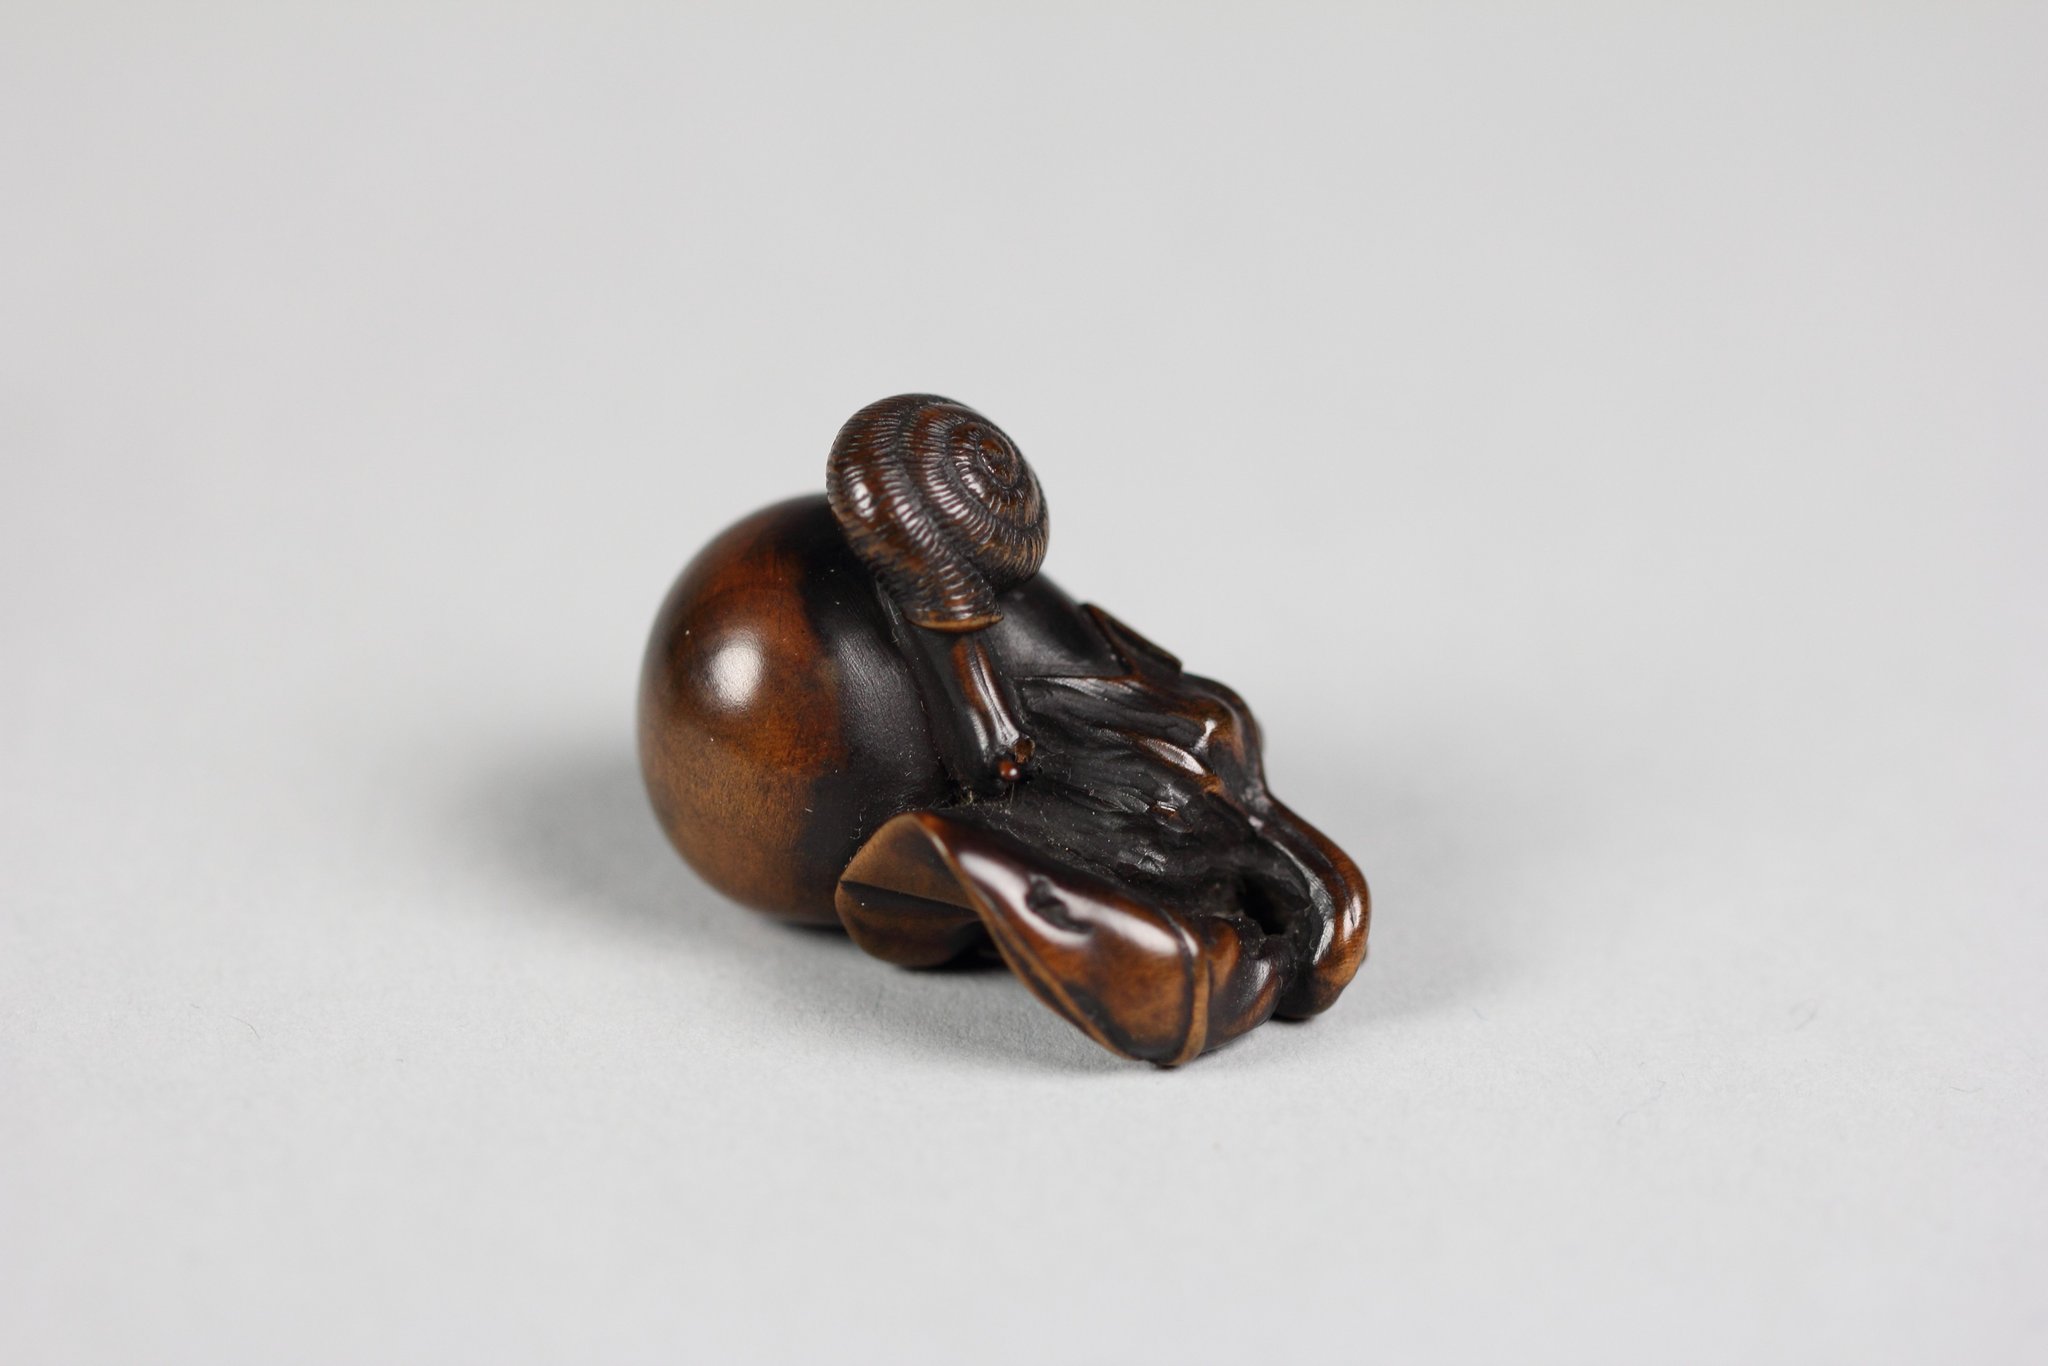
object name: netsuke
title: Netsuke of Snail on Eggplant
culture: japanese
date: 1801-1900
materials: wood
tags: eggplants,snails